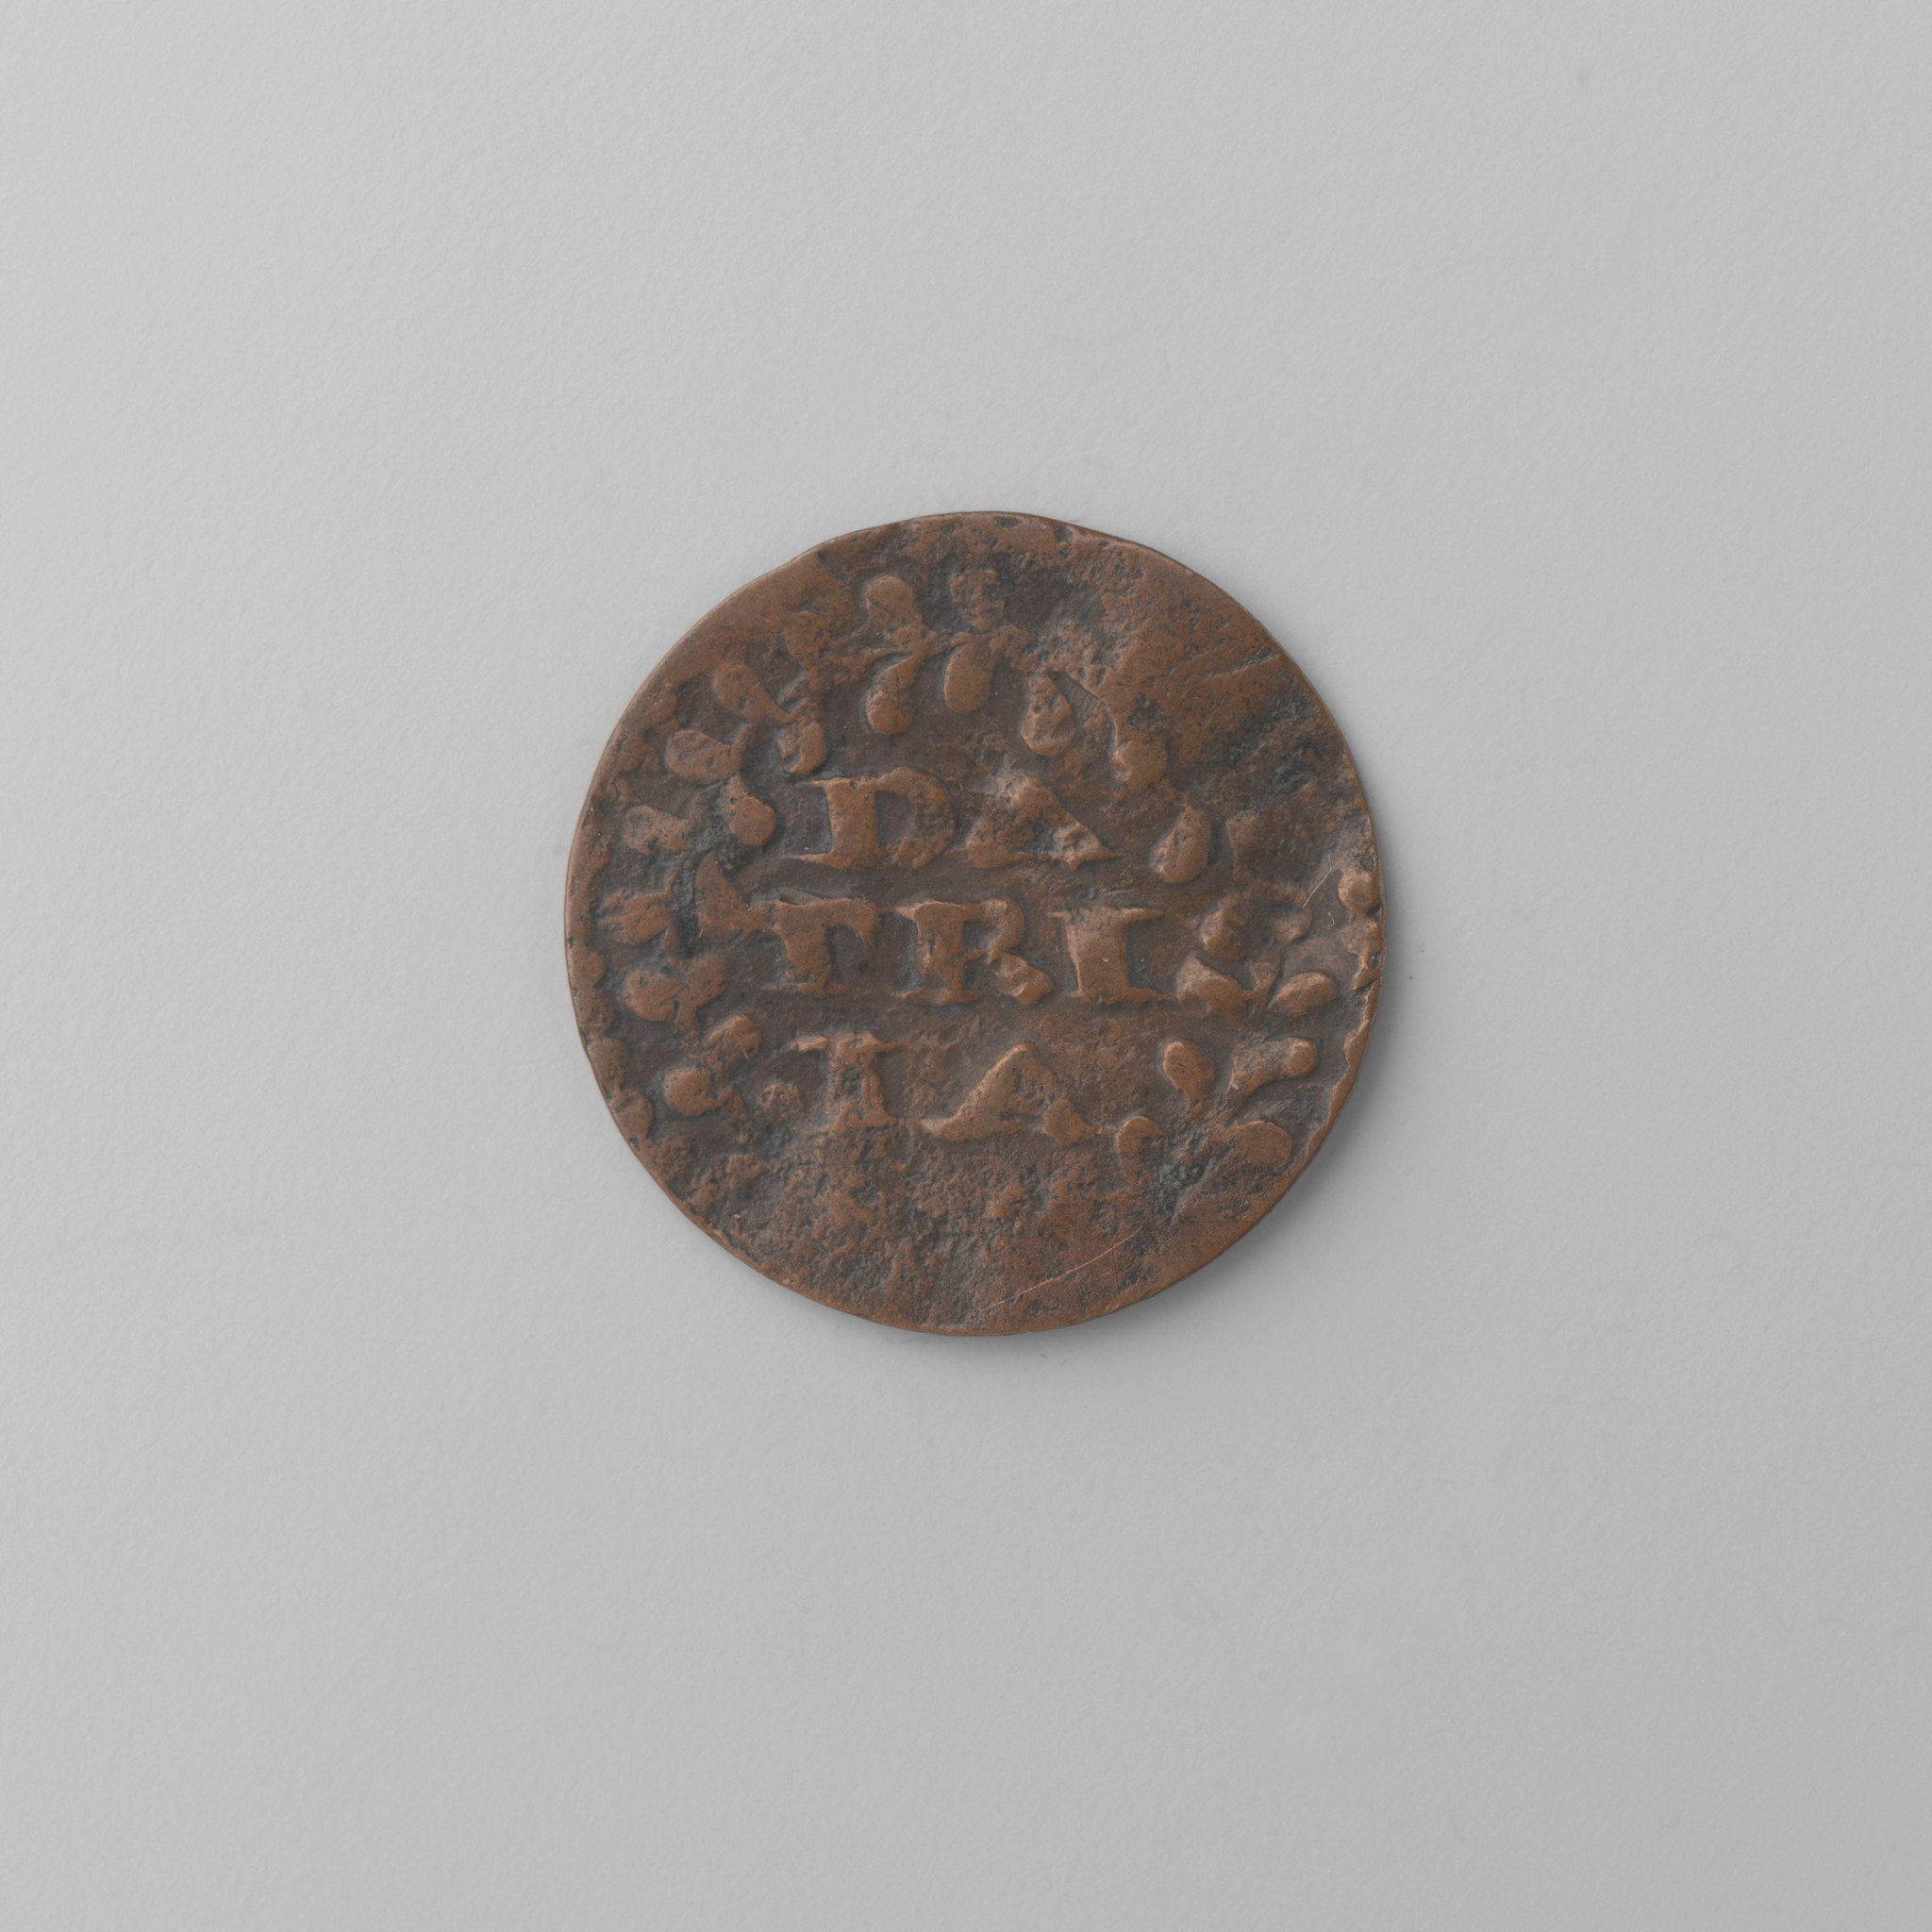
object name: coin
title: Reckheimse duit van Ferdinand van Aspremont-Lynden (1636-1665)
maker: heer van reckheim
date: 1636-1665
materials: copper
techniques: striking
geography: rekem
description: Koperen munt. Voorzijde: versierd gekroond wapenschild van Deventer. Keerzijde: binnen een krans drie-regelig opschrift.